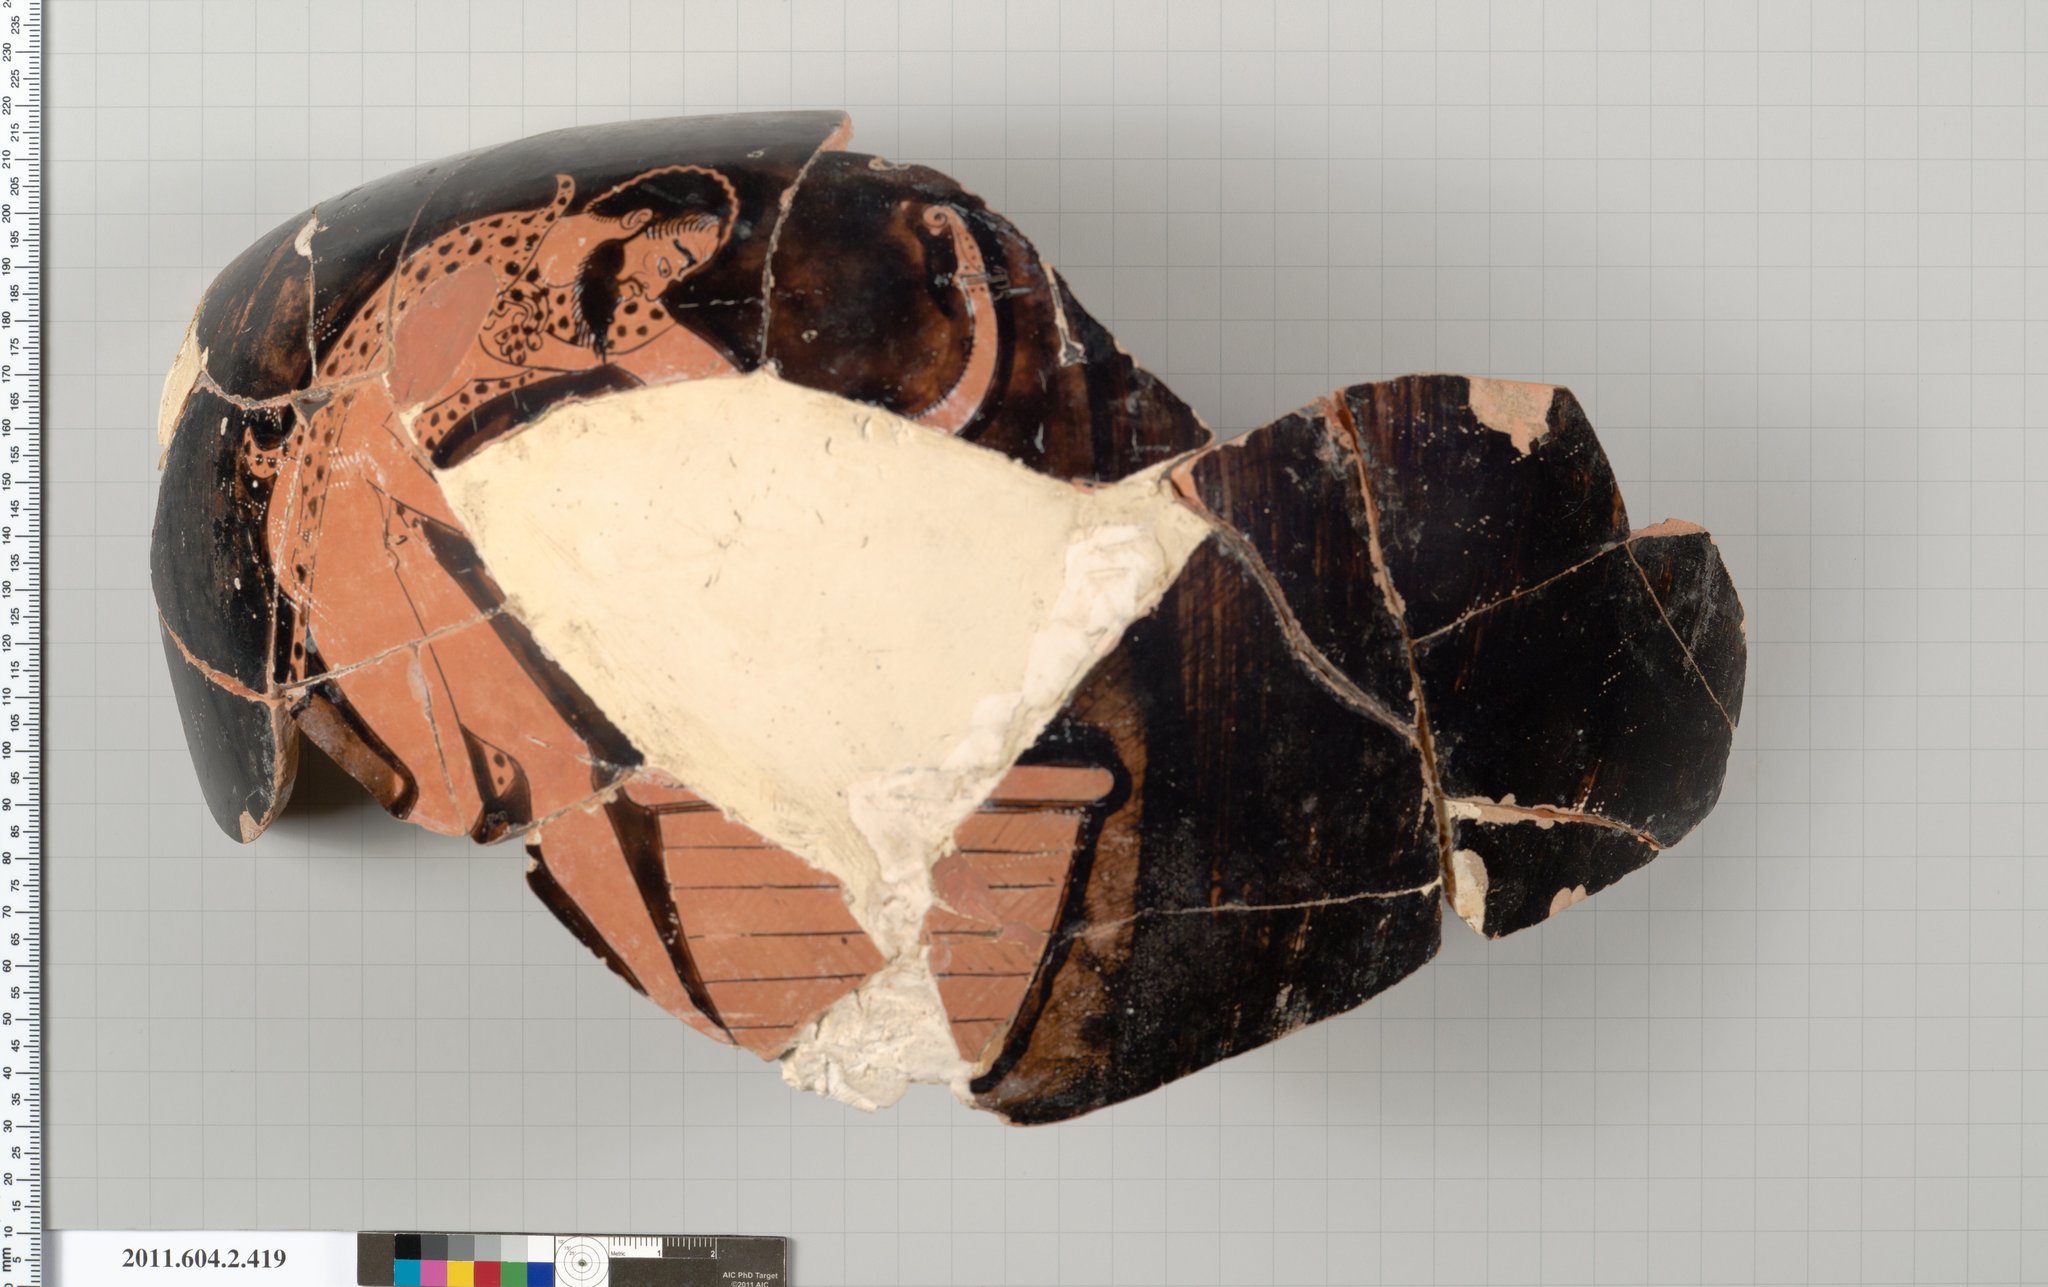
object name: column krater fragment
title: Terracotta fragment of a column-krater (bowl for mixing wine and water)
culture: greek, attic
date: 490-480 BCE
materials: terracotta